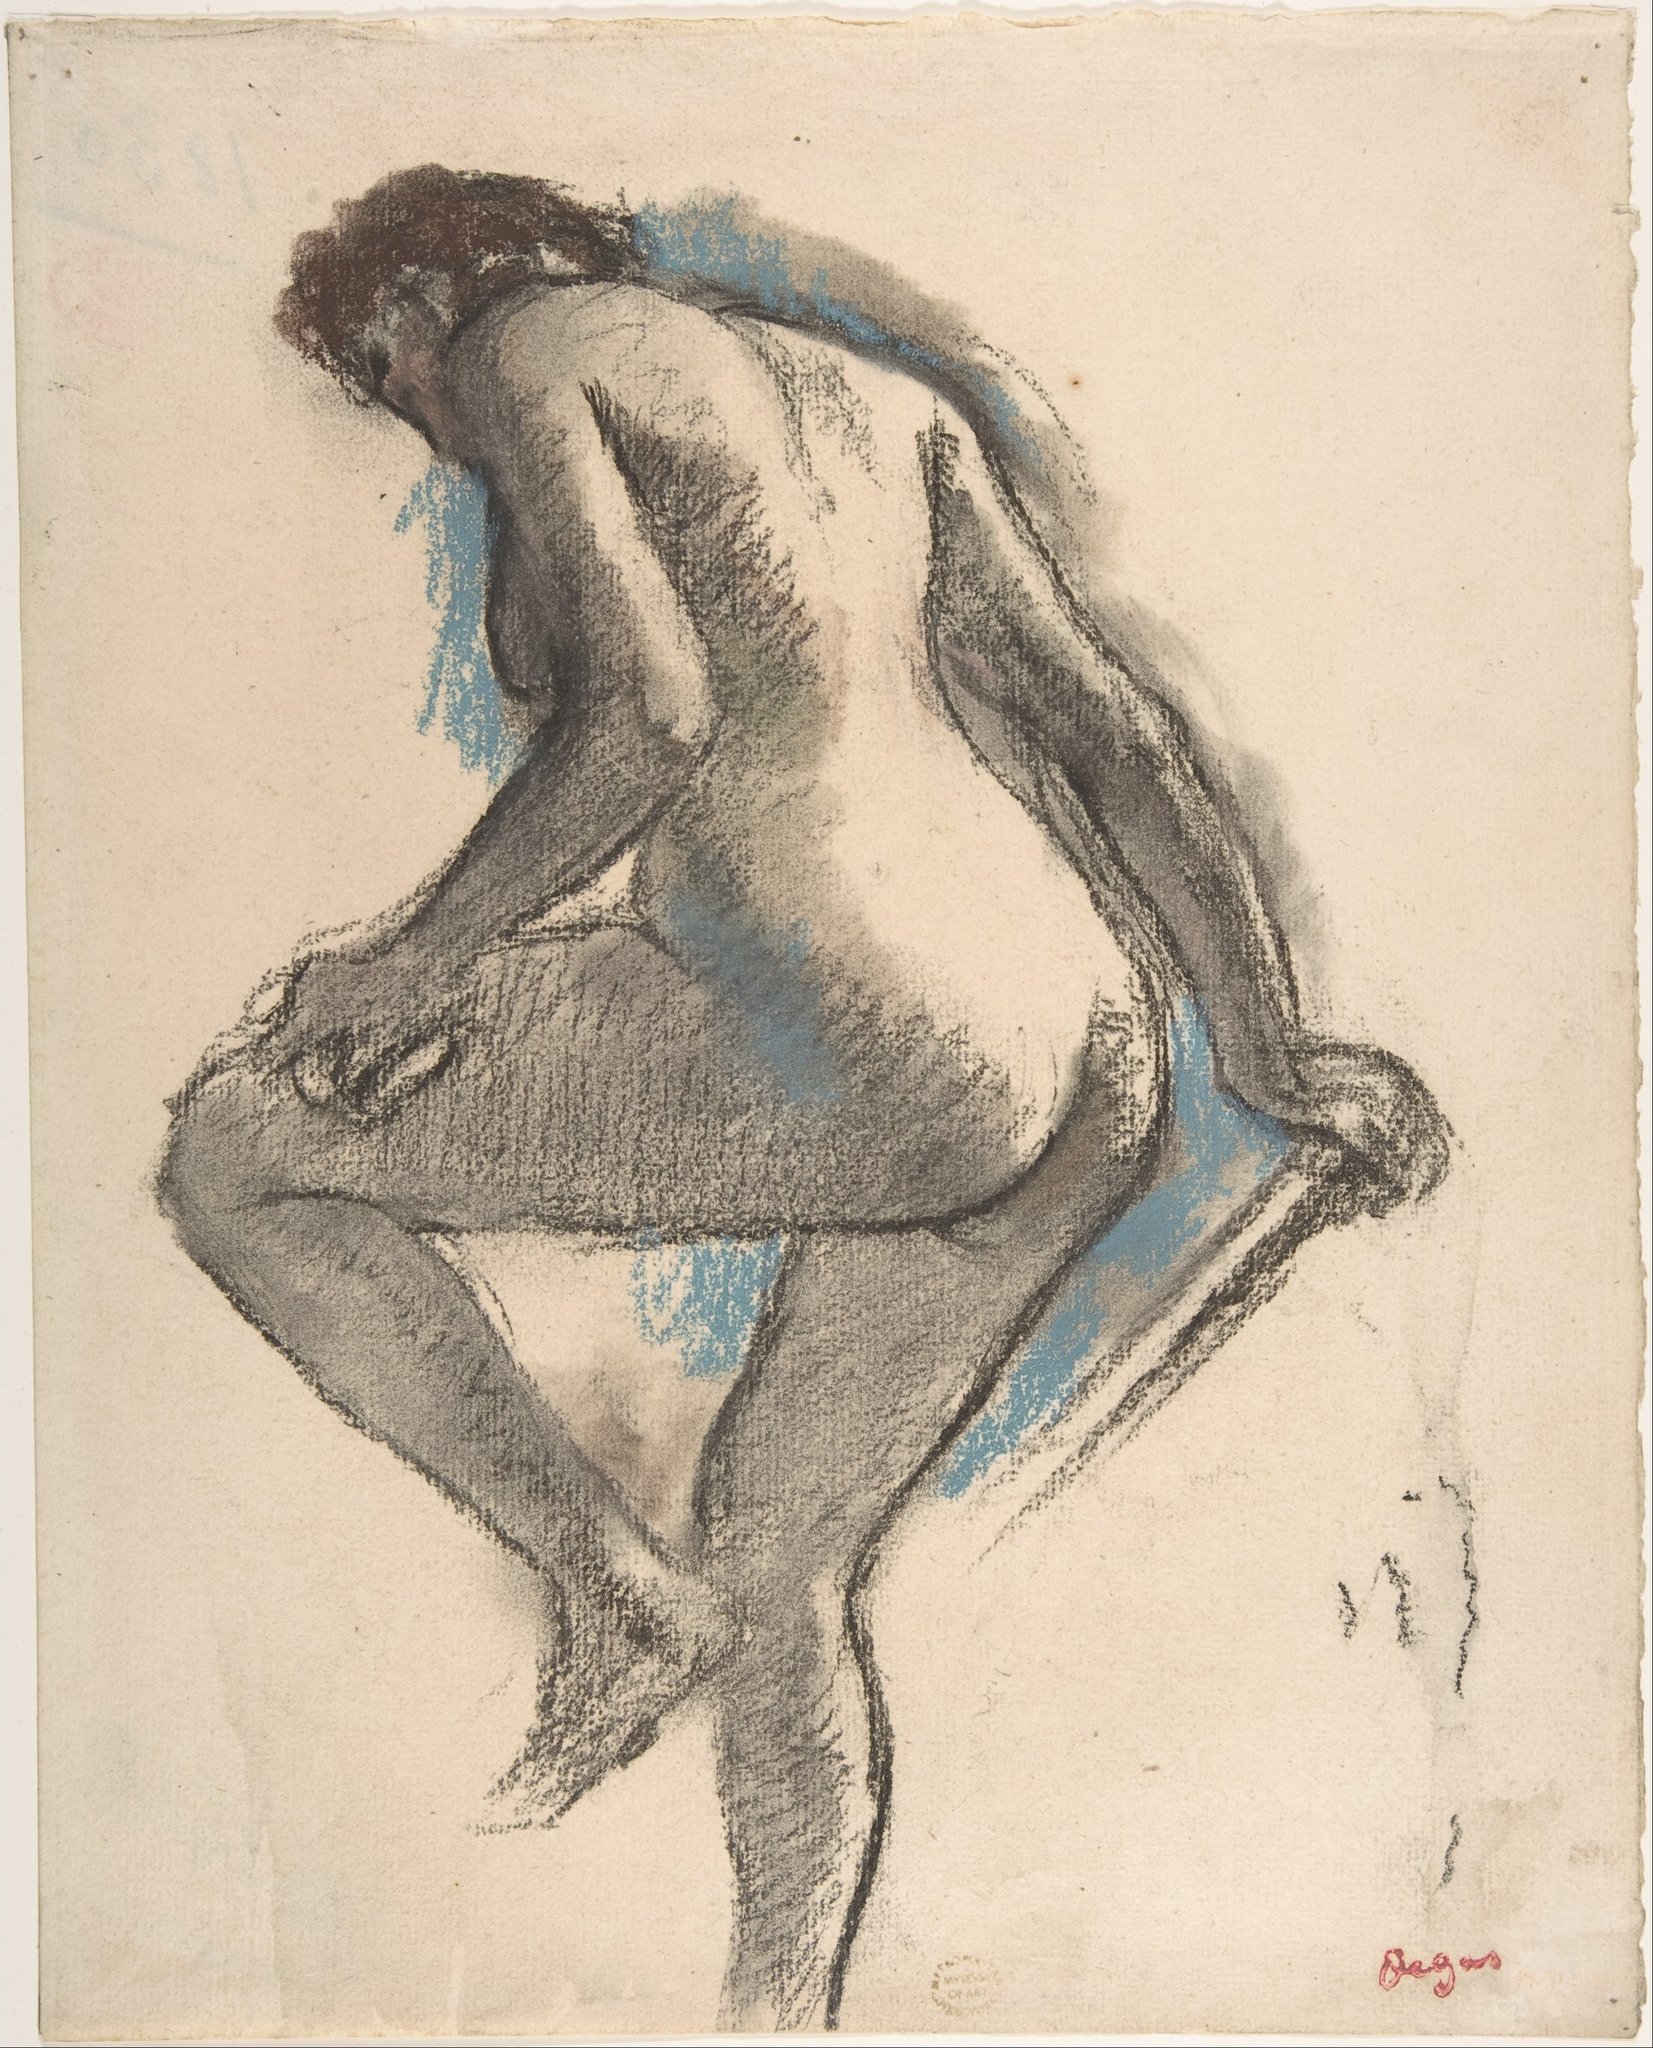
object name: drawing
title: Bather Sponging Her Knee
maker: edgar degas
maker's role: artist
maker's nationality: french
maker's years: 1834-1917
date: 1883-1884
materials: charcoal, paper, pastel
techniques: wash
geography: france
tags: female nudes,bathing